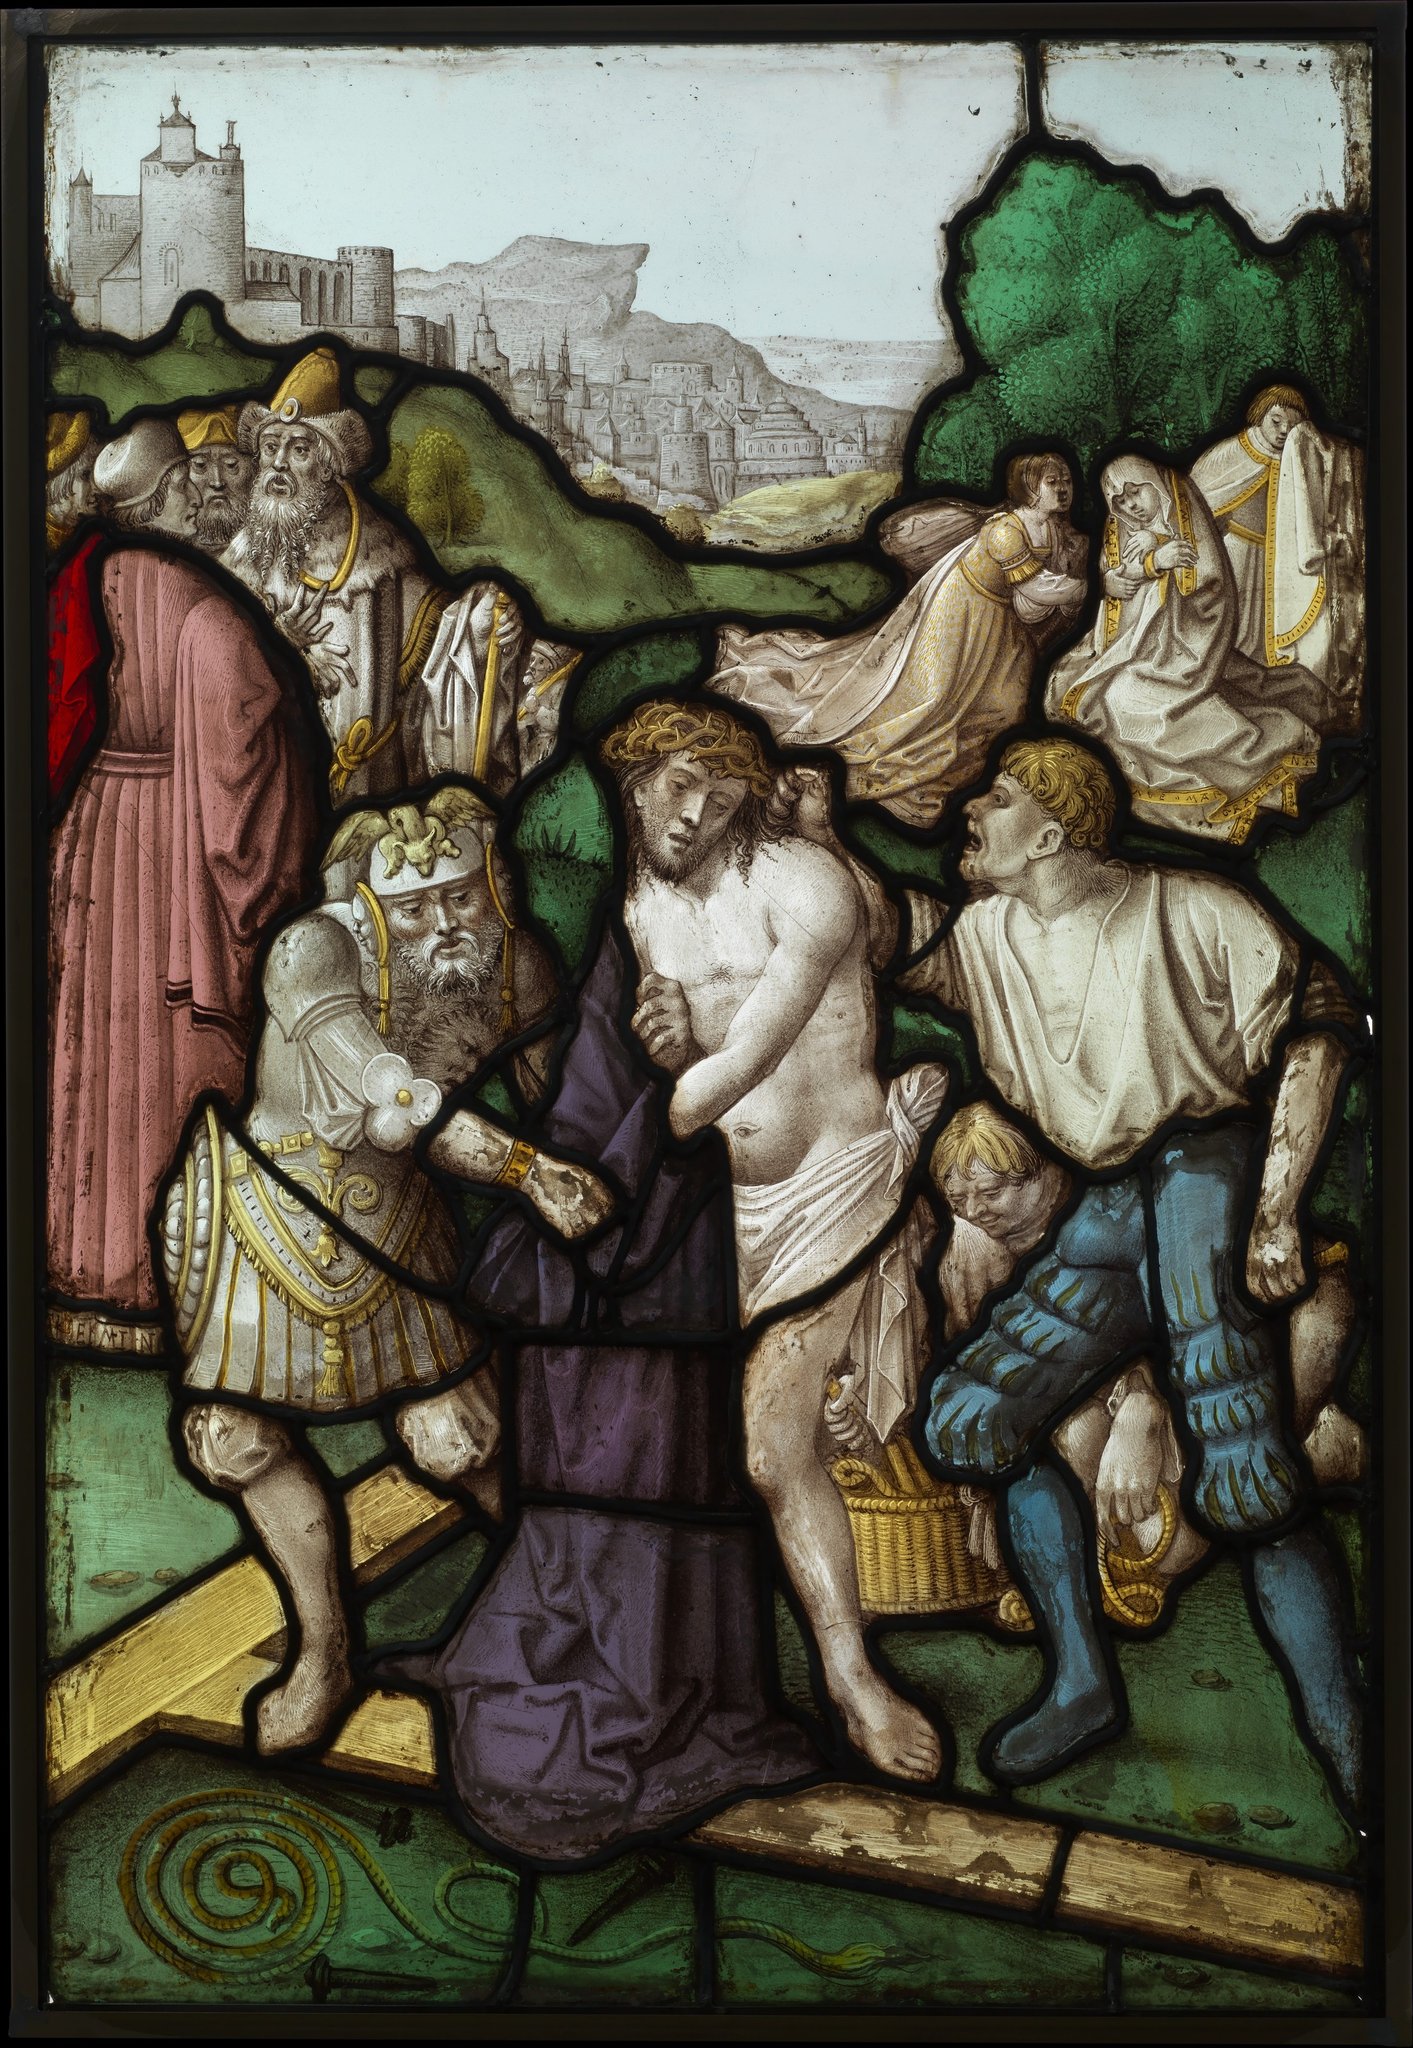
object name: panel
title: Preparation for the Crucifixion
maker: jan rombouts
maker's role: maker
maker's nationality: south netherlandish (duchy of brabant)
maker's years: 1475-1535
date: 1520-1525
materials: glass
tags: men,jesus,crucifixion